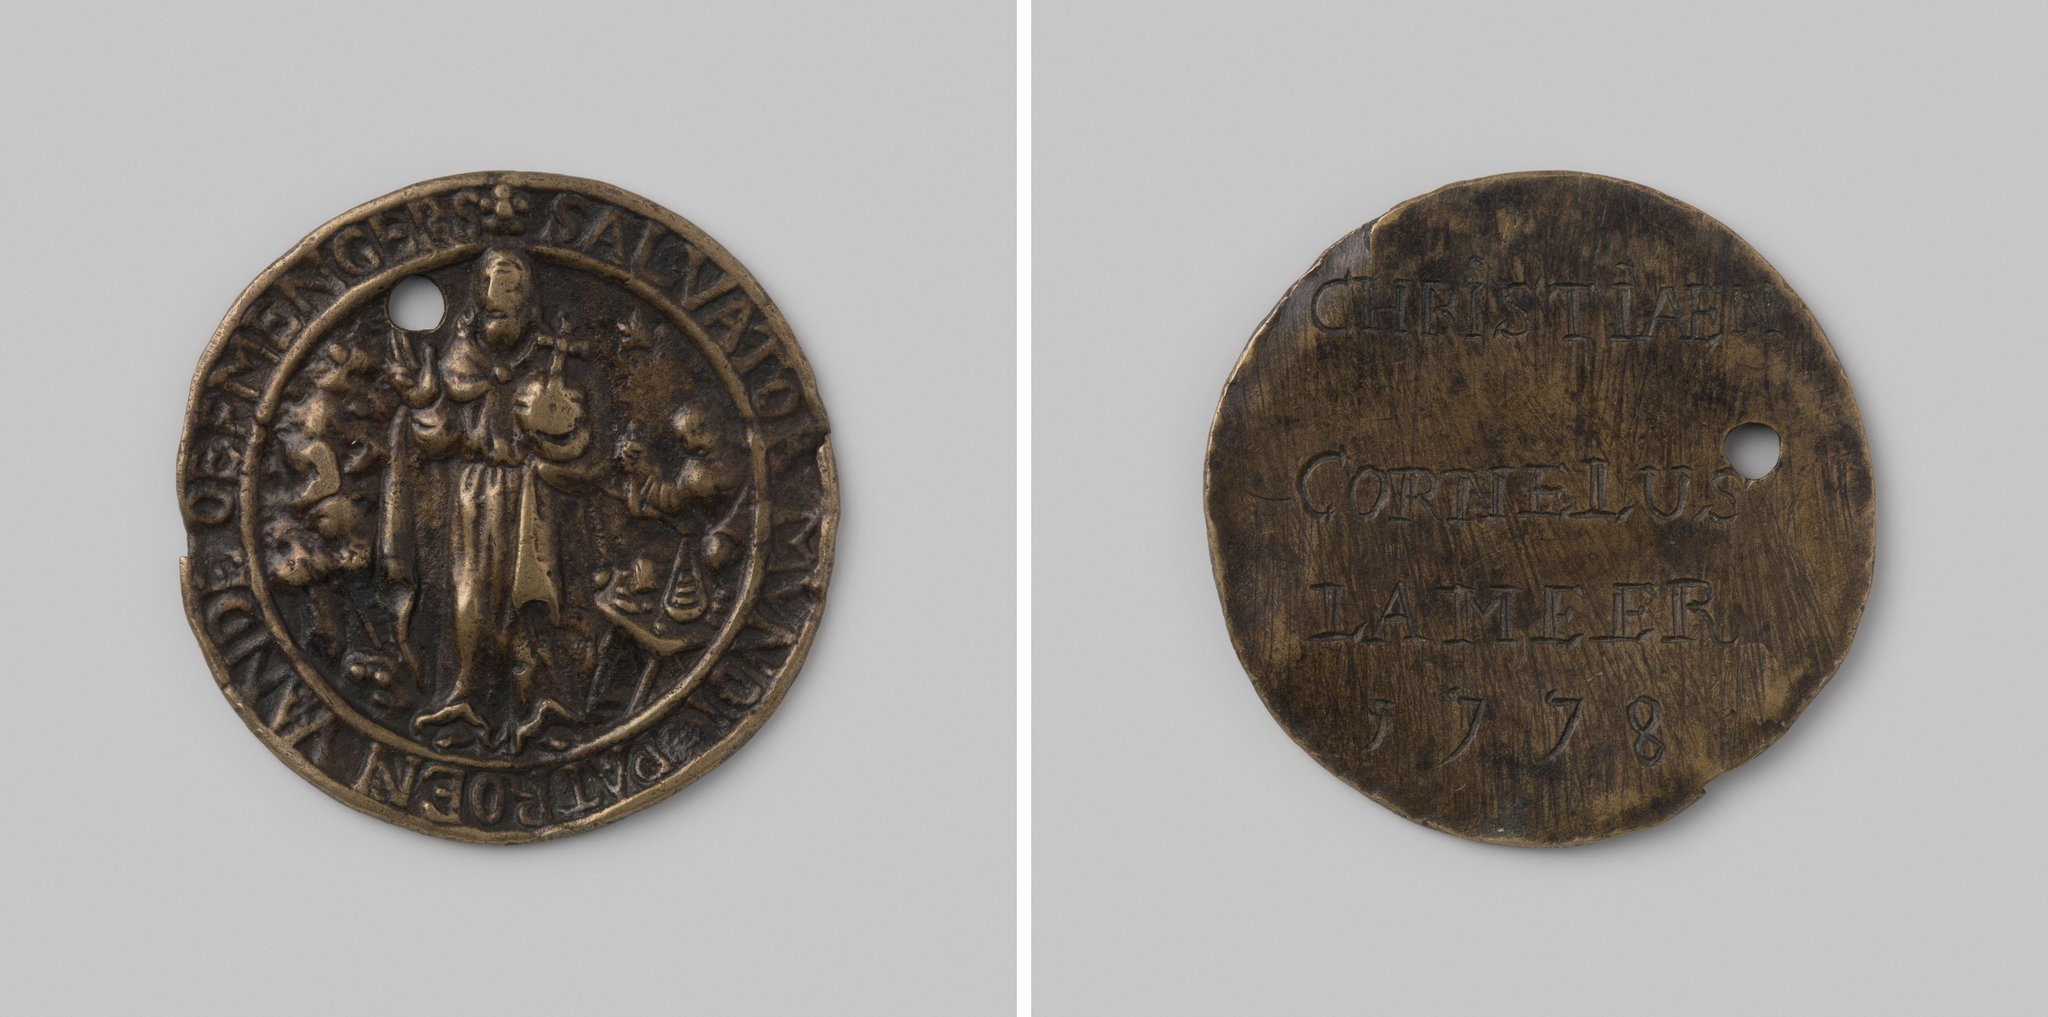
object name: medal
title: Presentiepenning van het Ooftmengersgilde te Maastricht 1716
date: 1716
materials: brass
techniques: casting, engraving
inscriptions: circumscription: ‘(rozet) SALVATOR MVNDI PATROEN VANDE OEFMENGERS’, inscription: ‘CHRISTIAEN / CORNELIUS / LAMEER / 1778’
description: Gegoten messing penning, op de voorzijde Christus zegenend tussen een fruitplukker en een fruitverkoopster, met omschrift, op de gladgeslepen keerzijde vier regels tekst gegraveerd, op naam van Christiaen Cornelus Lameer 1778, met draaggat